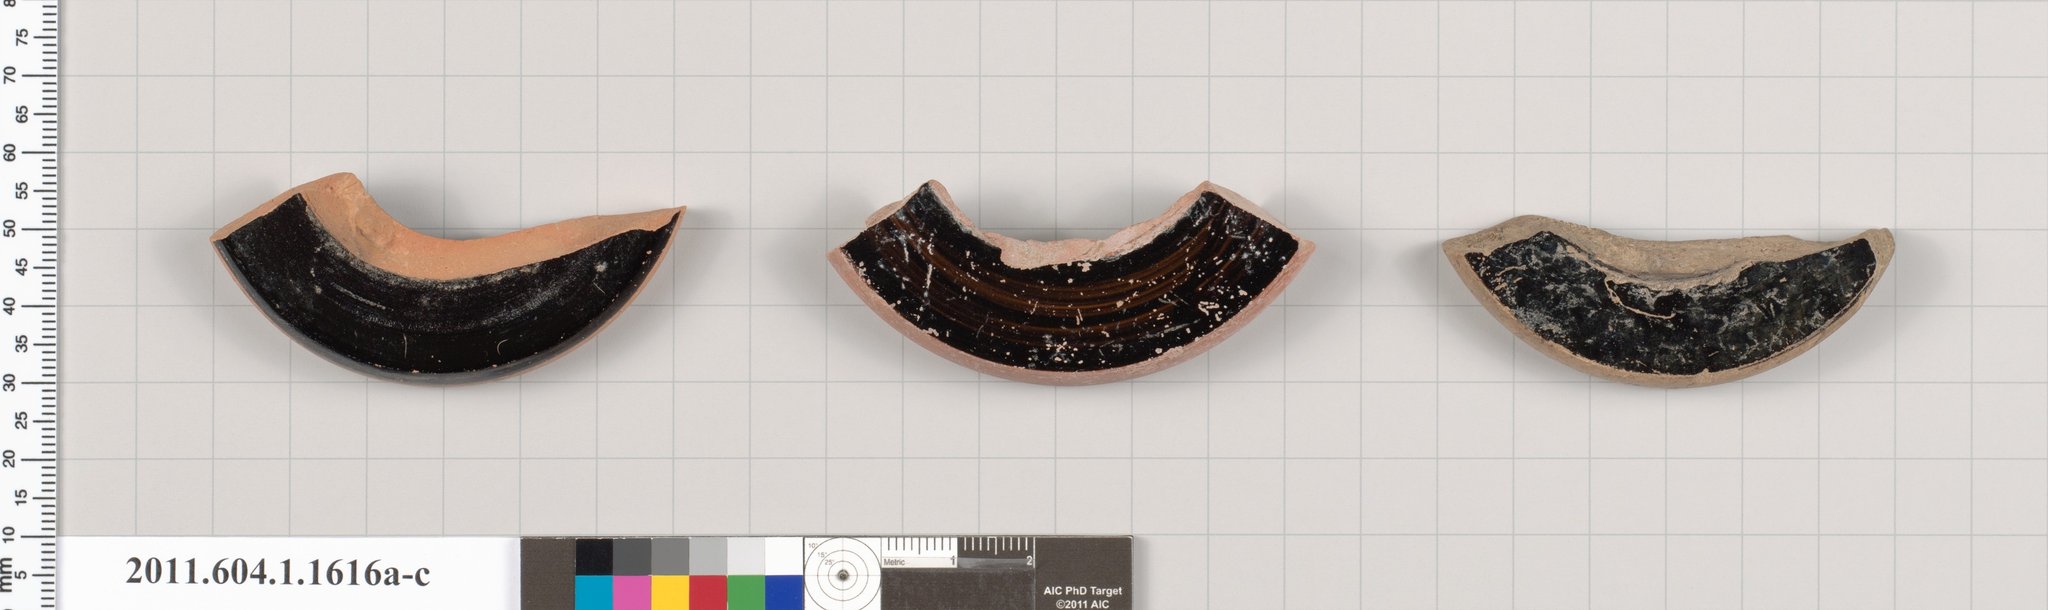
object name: kylix fragment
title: Terracotta fragments of kylikes (drinking cups)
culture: greek, attic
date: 500-401 BCE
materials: terracotta